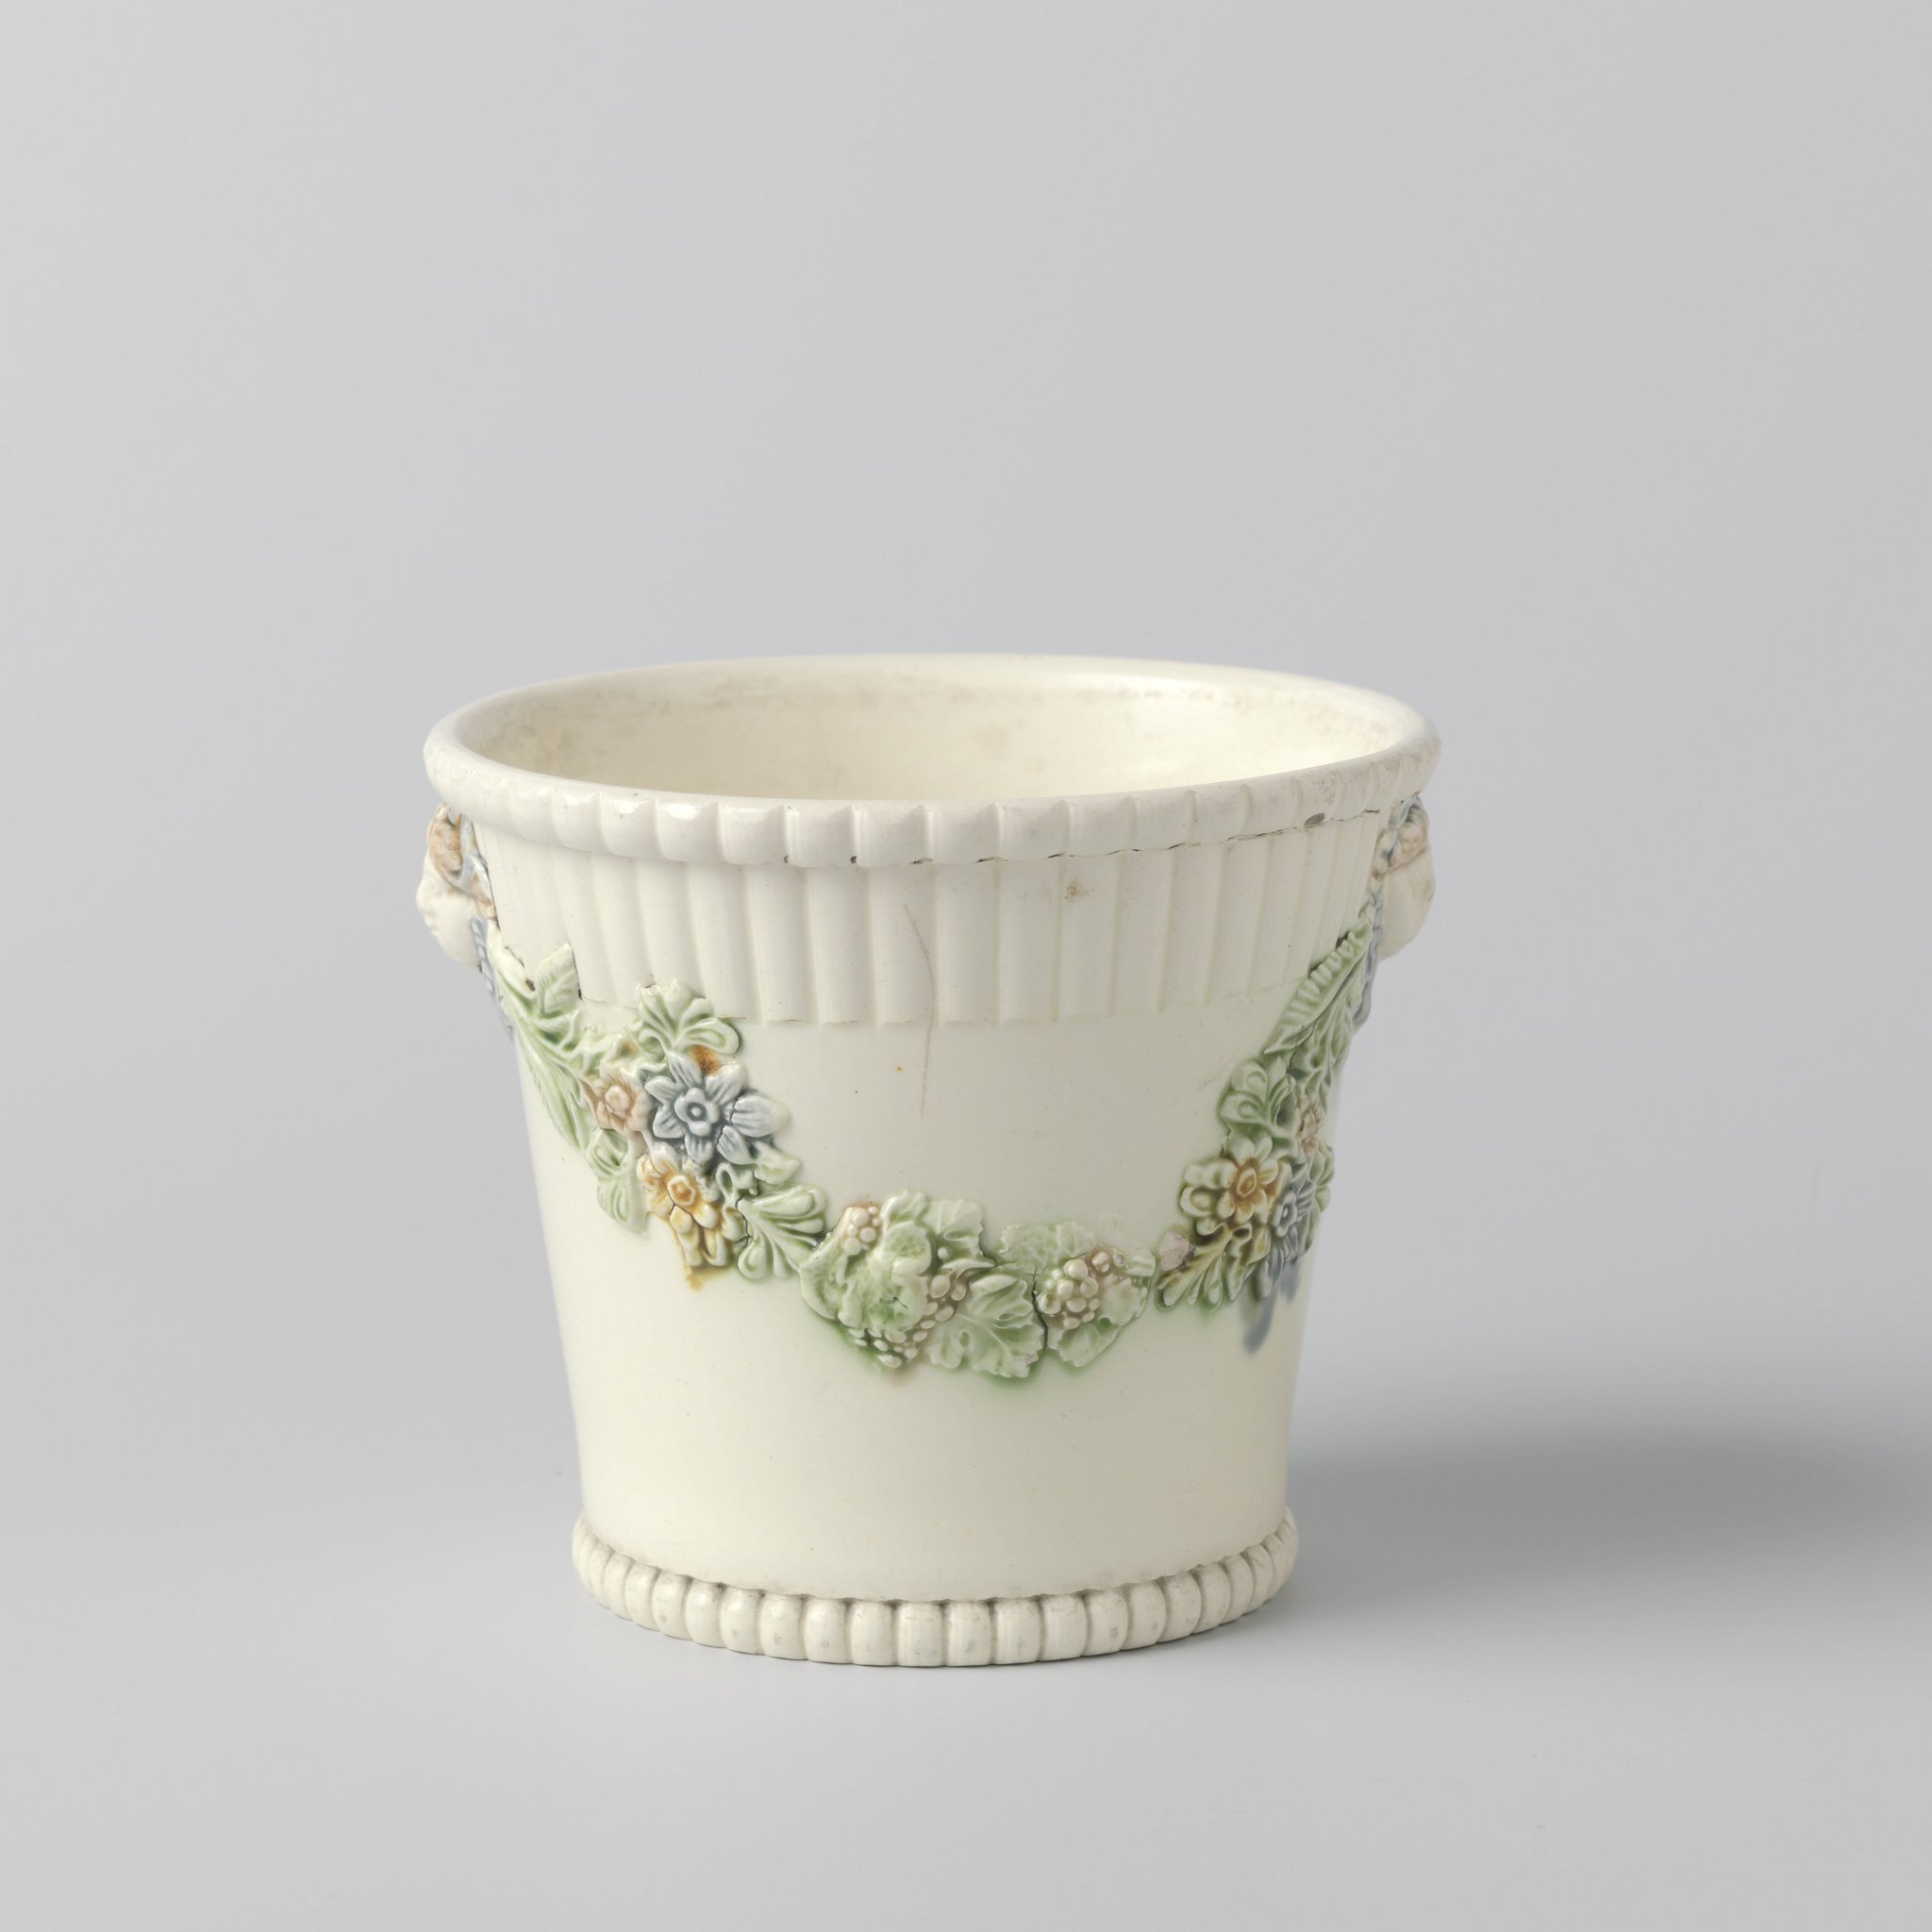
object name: flowerpot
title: Bloempot van hardgebakken aardewerk met een veelkleurige decoratie, Wedgwood.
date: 1780-1810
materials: earthenware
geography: england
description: Bekervormige bloempot van hardgebakken aardewerk. De boven- en onderrand zijn geribd. De pot is versierd met festoenen en maskers in reliëf. De pot is ongemerkt en hoort bij een pot met invnr. BK-NM-12028-12-A.